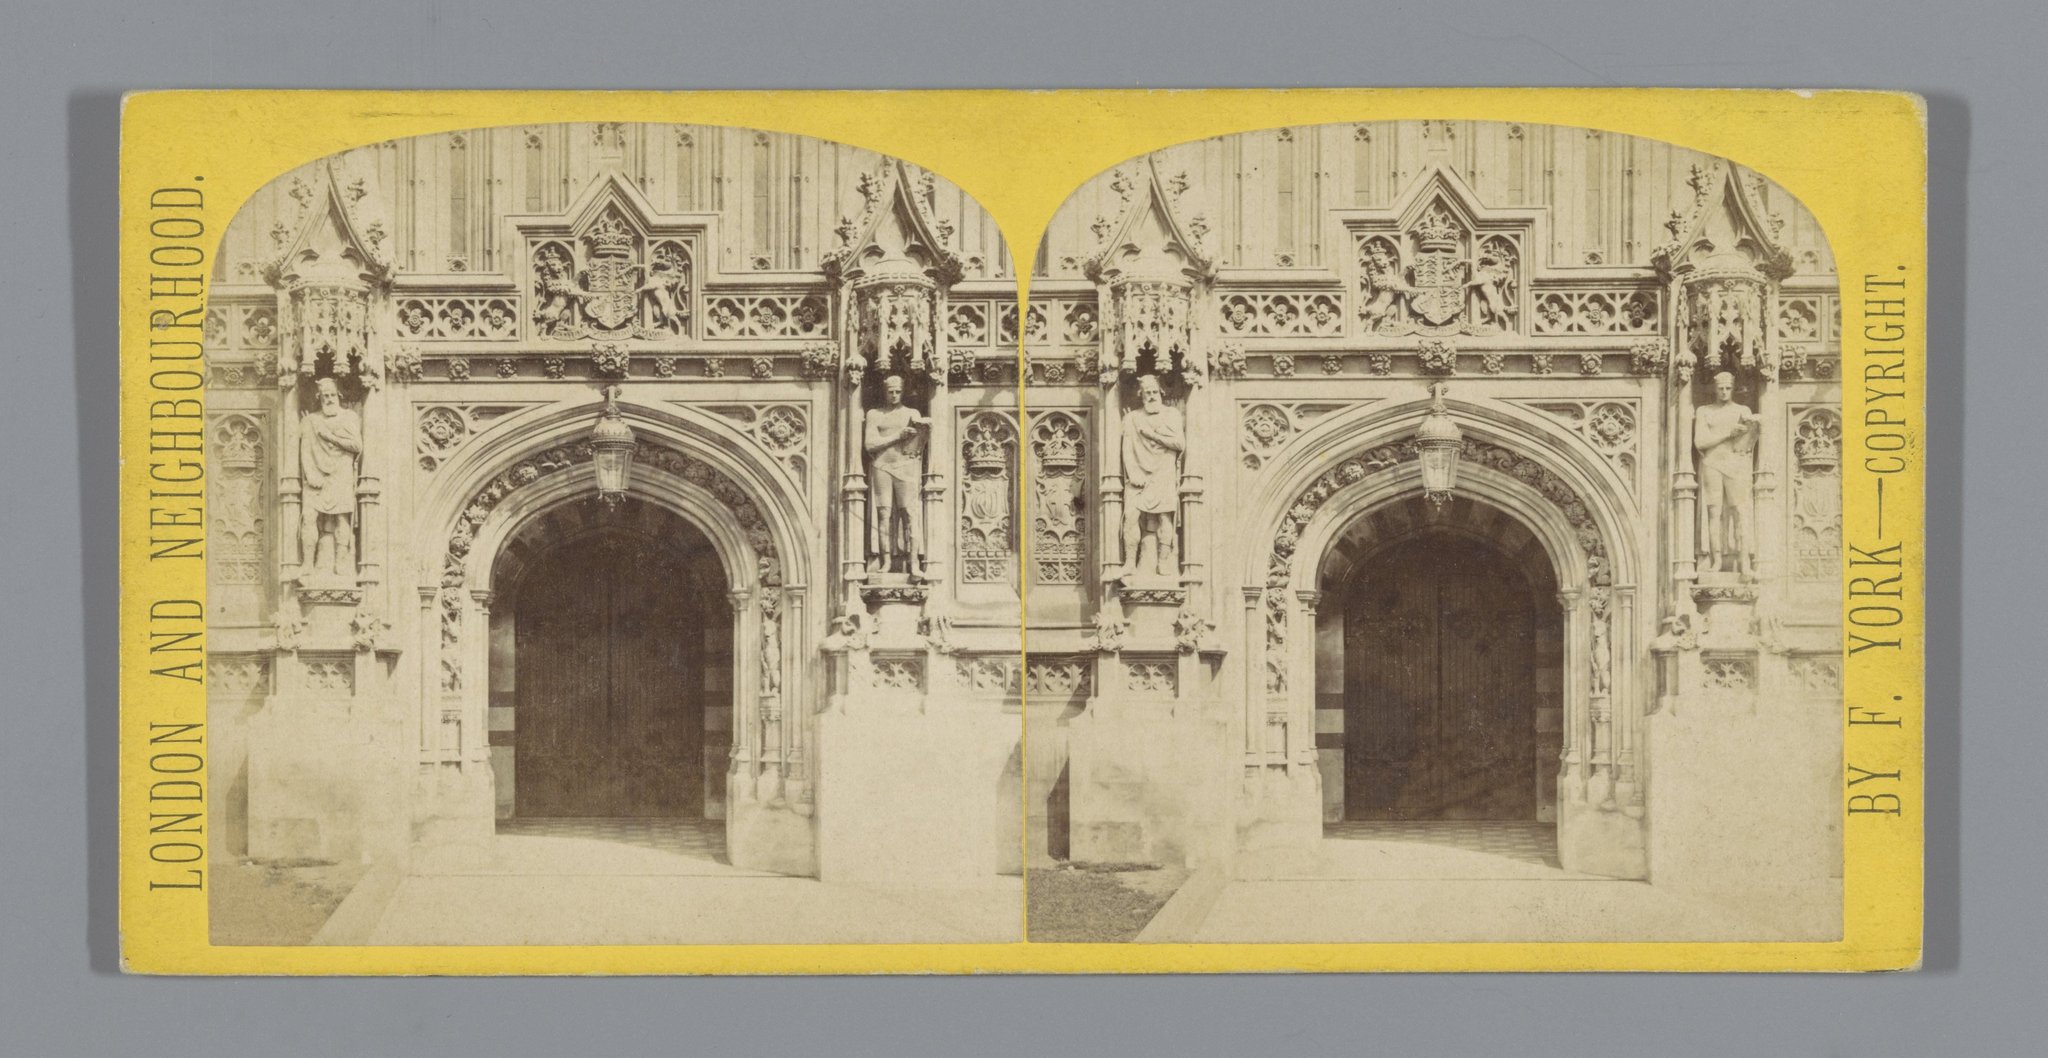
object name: stereograph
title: Portaal van de toegang naar de kloosters vanaf het Palace of Westminster in Londen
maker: frederick york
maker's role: fotograaf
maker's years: 1823-1903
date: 1860-1880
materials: cardboard, photographic support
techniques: albumen print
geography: london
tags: parts of church exterior and annexes: portal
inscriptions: number: ‘59.’